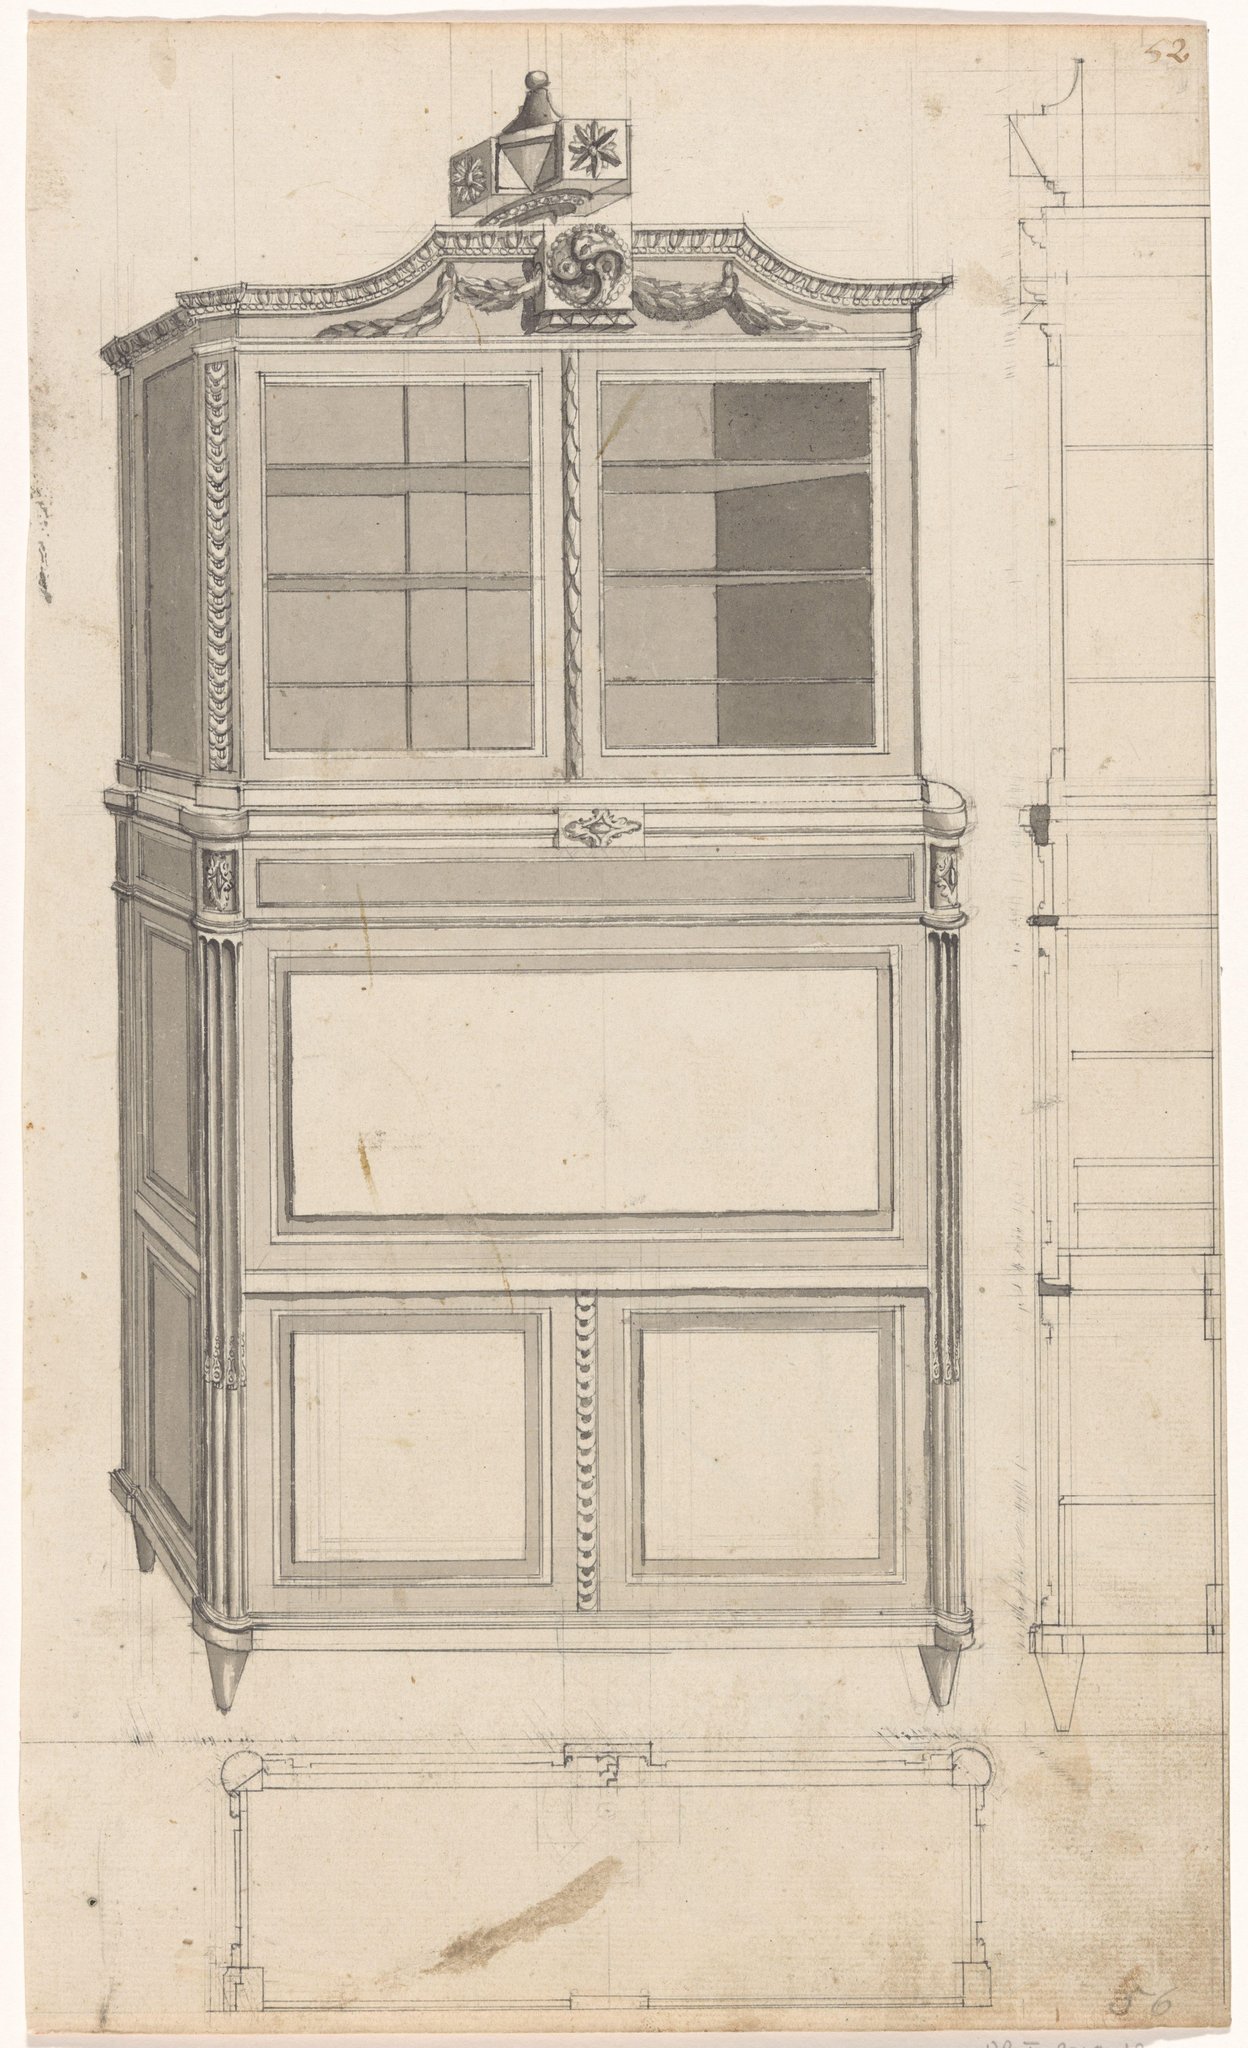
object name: design drawing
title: Ontwerp voor een secretaire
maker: Anonymous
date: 1780-1790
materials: graphite, ink, paper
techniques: brush, pen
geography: germany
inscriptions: number: ‘52’, watermark: ‘Wapen met schuine balk onder lelie.’, number: ‘56’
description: Ontwerp voor een secretaire met een opstand in de vorm van een boekenkast met deuren met glazen ruiten, met rechts een dwarsdoorsnede en onderaan een plattegrond. Verso een plattegrond van een kansel met een trap.